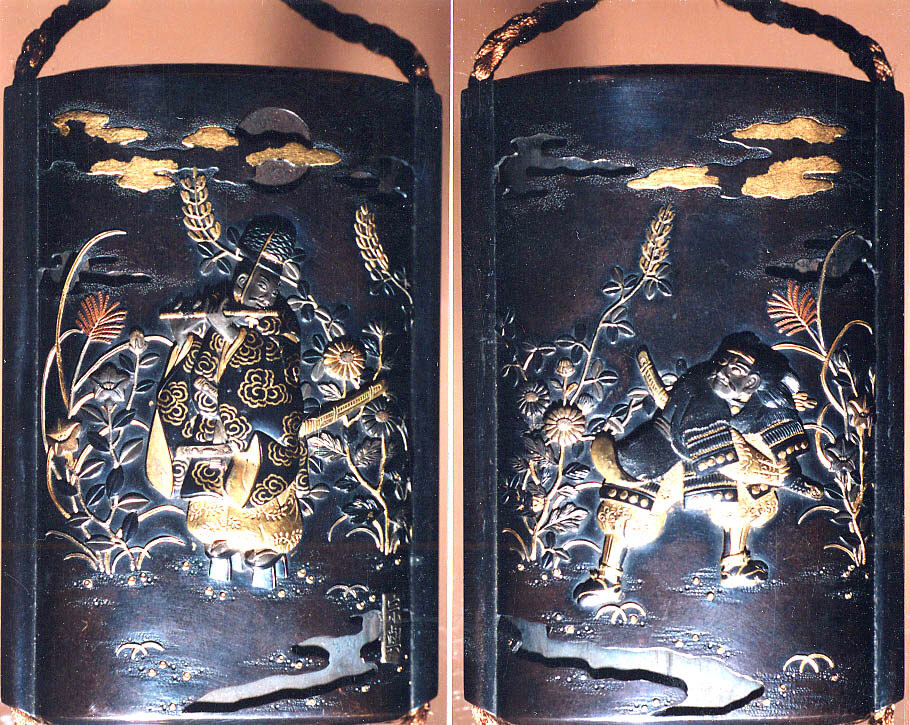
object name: inrō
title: Case (Inrō) with Design of Courtier Playing Flute among Autumn Grasses (obverse); An Assassin (reverse)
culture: japanese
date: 1801-1900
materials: metal, silver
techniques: incising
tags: men,flutes,flowers